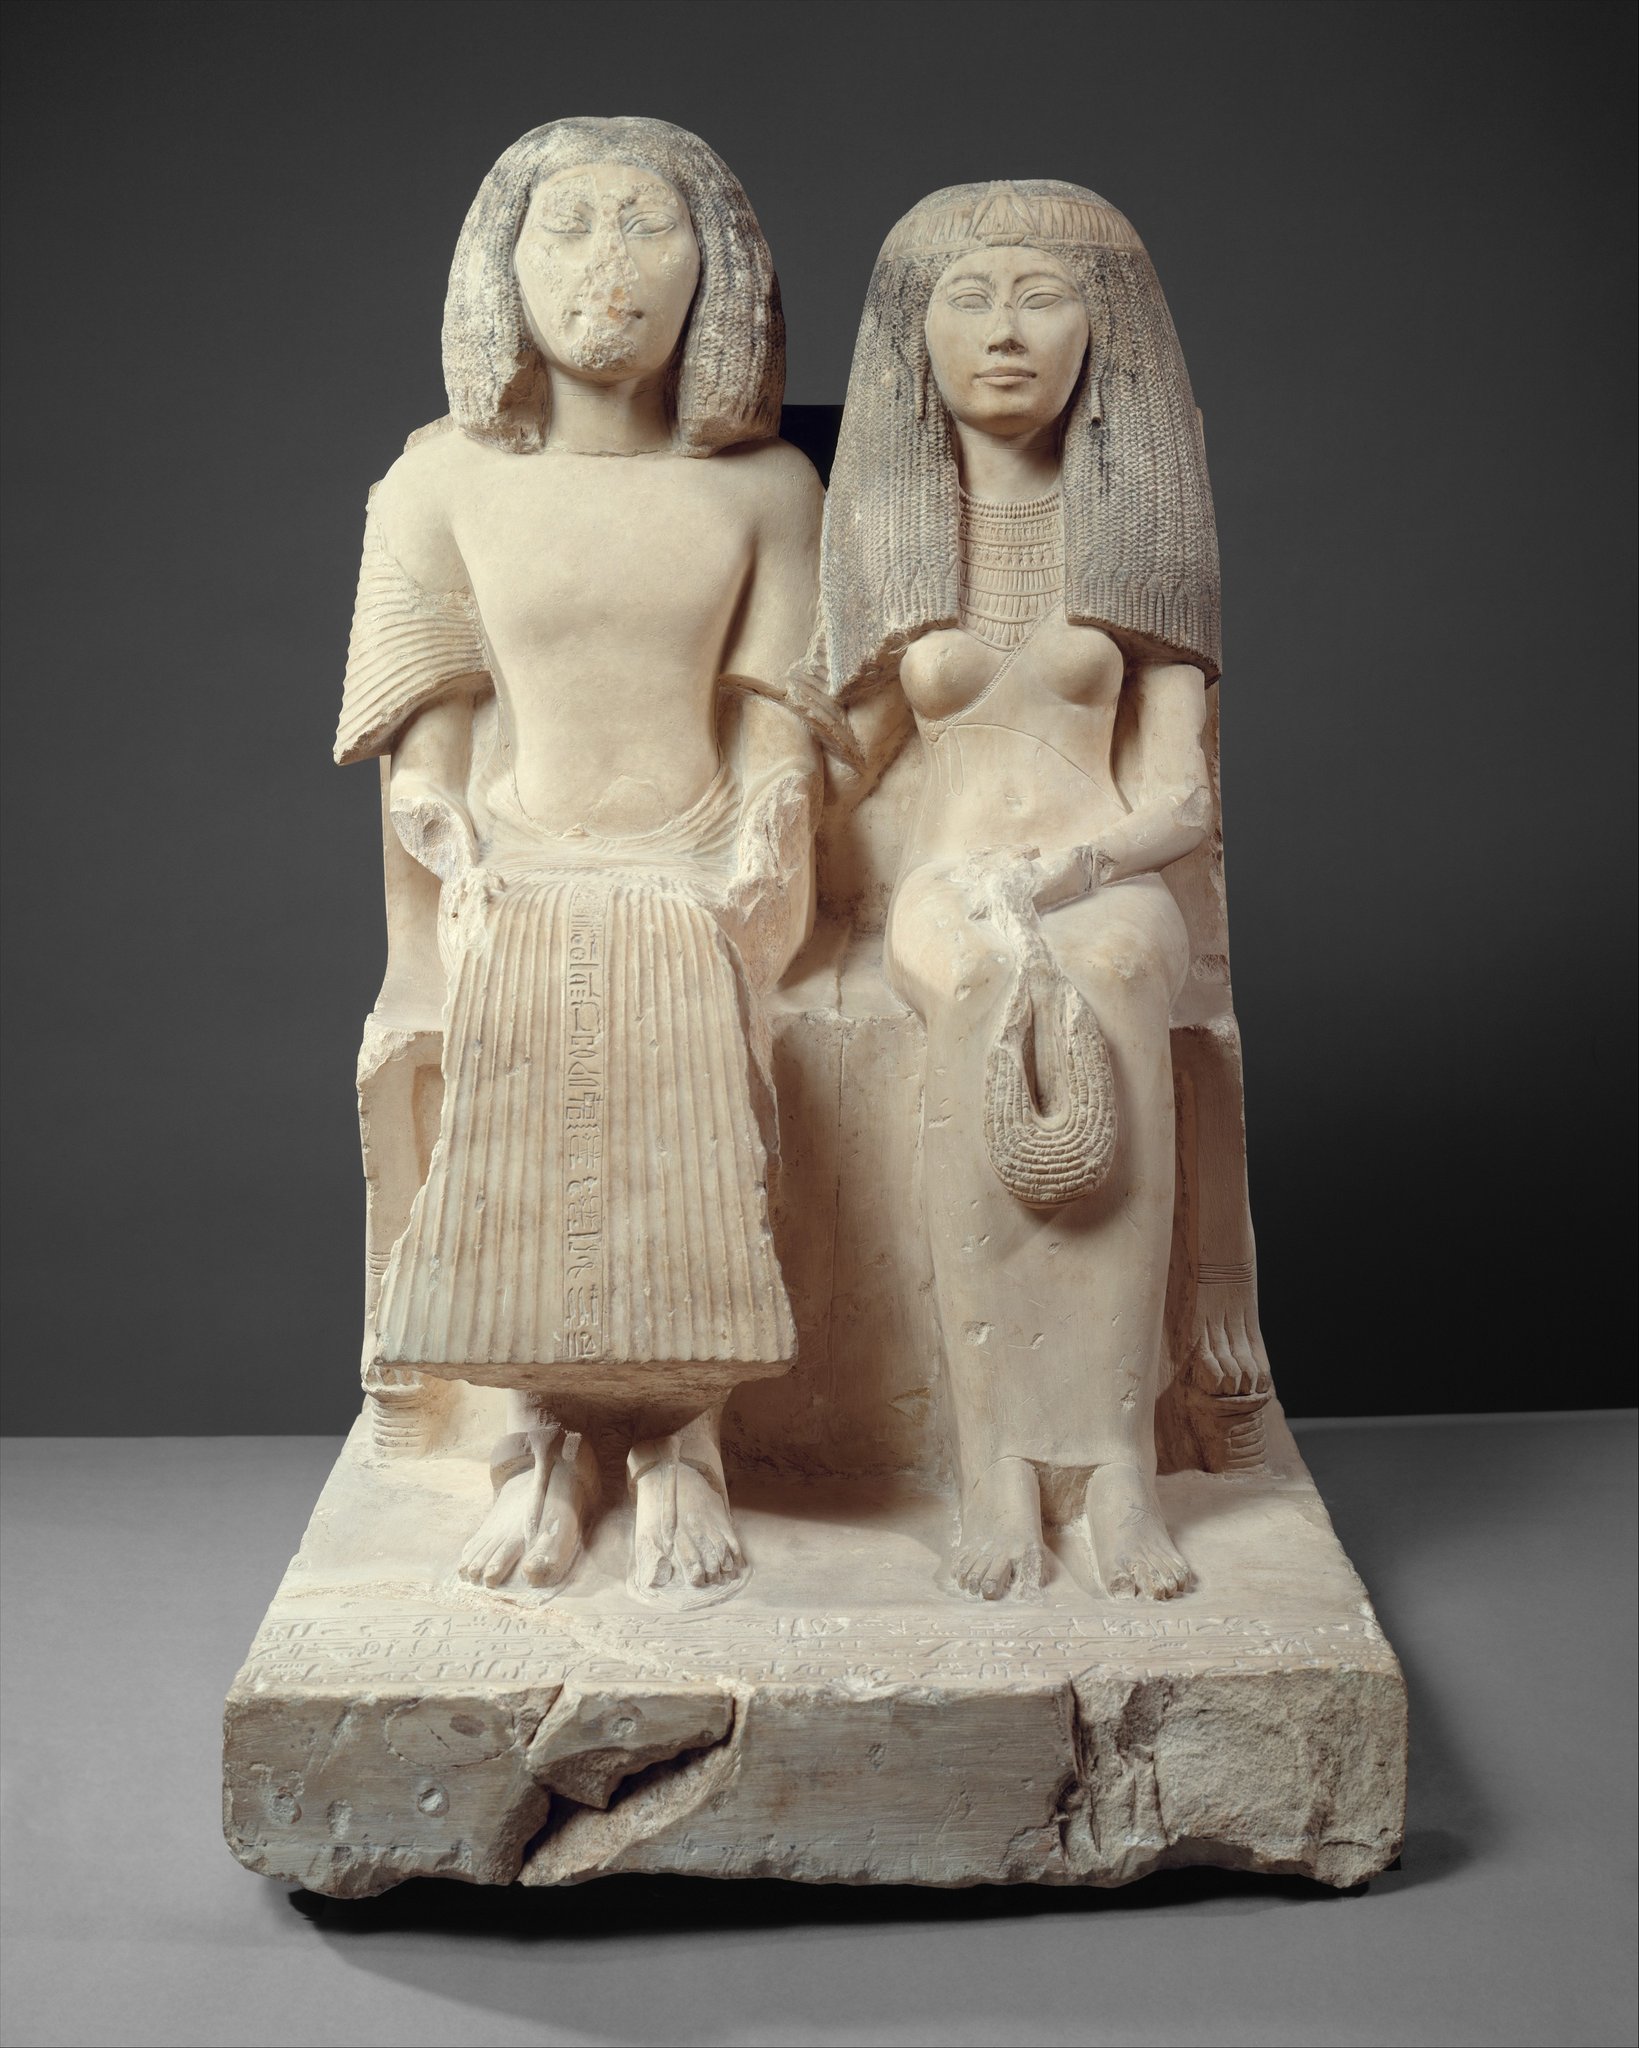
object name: statue, yuny, renenutet, pair, menat, music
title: Yuny and His Wife Renenutet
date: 1294-1279 BCE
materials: limestone, paint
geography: egypt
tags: couples,men,women,hieroglyphs